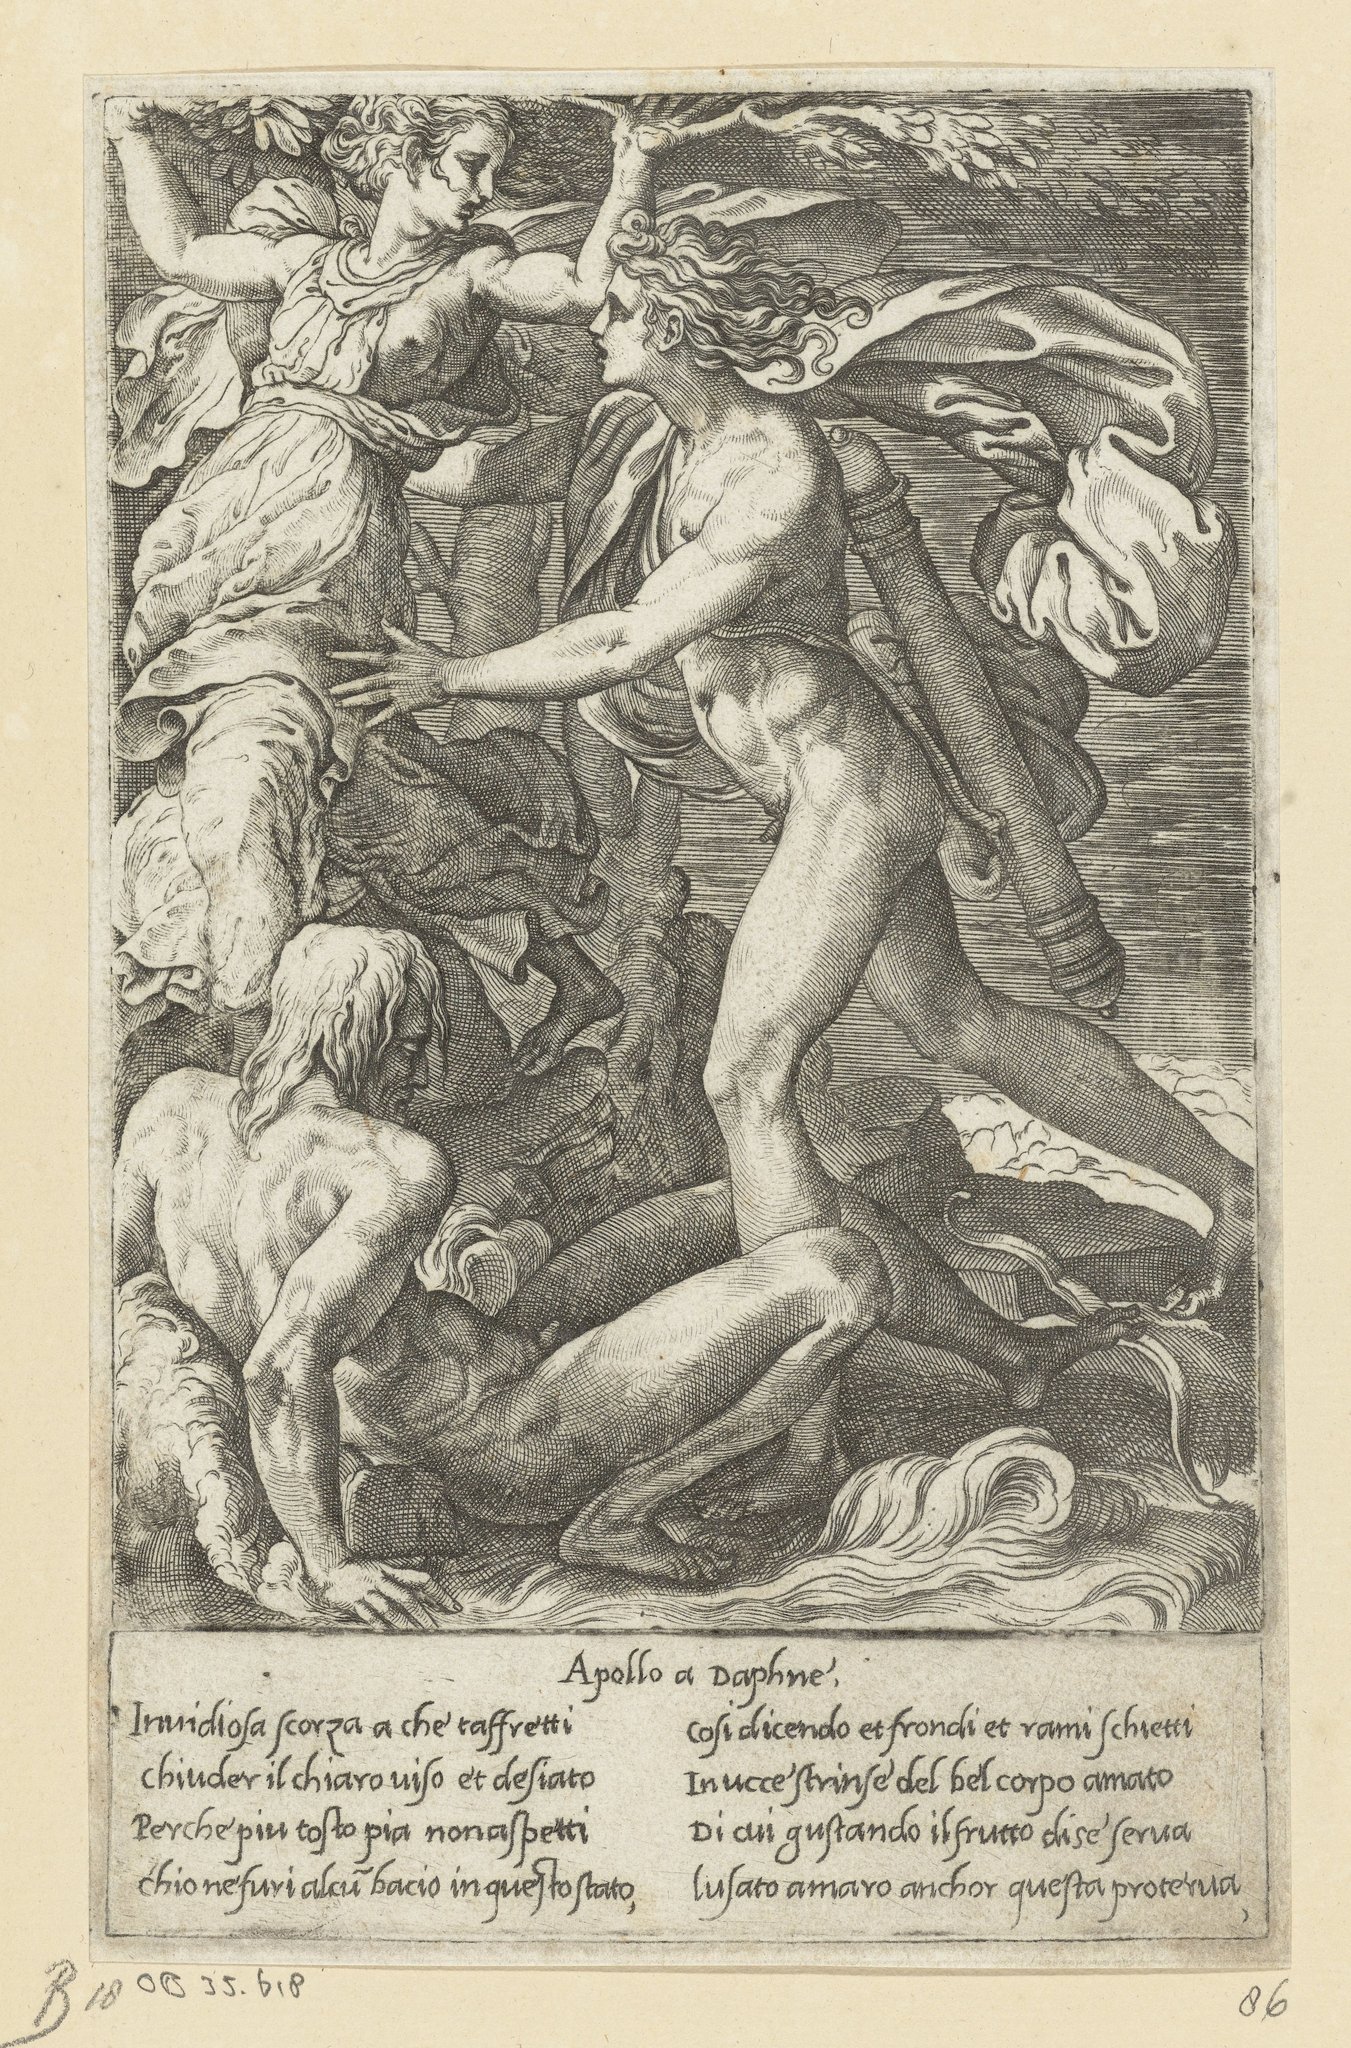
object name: print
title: Loves of the Gods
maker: giovanni jacopo caraglio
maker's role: goldsmith, print maker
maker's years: 1500-1565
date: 1515-1565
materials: paper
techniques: engraving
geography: italy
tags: apollo pursuing the nymph daphne (as yet not metamorphosed)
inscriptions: collector's mark: Lugt 240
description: De naakte Apollo achtervolgt de vluchtende Daphne. Haar opgeheven armen krijgen al takken en bladeren. Op de voorgrond links ligt een riviergod. In ondermarge Italiaans vers in twee kolommen.